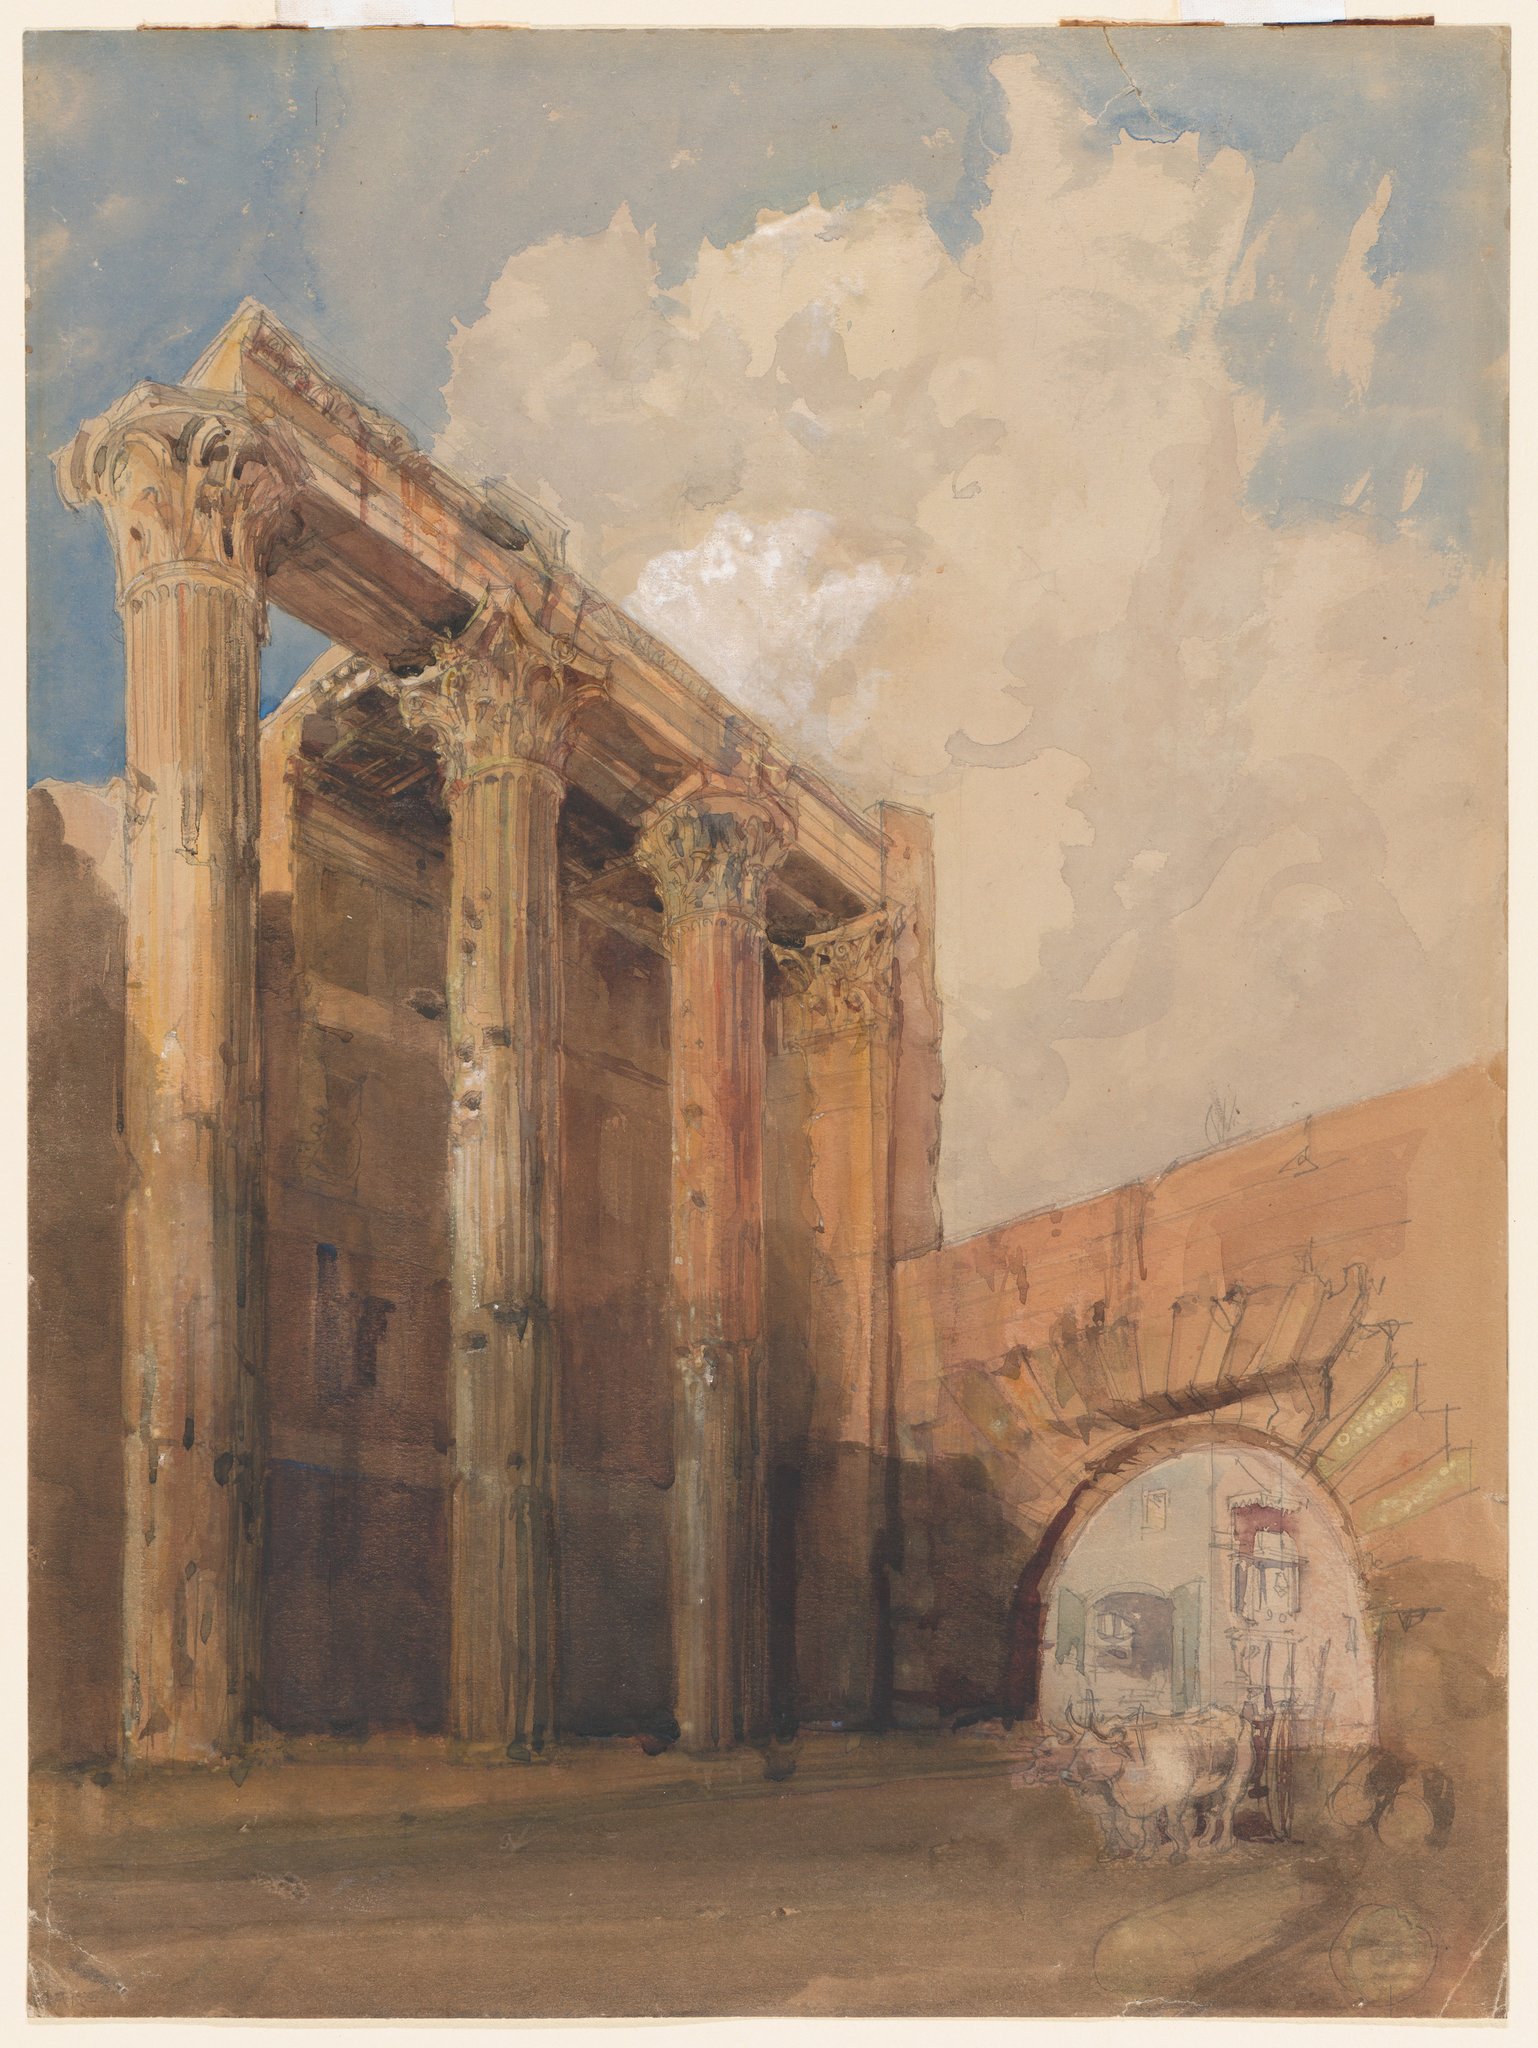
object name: drawing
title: Temple of Mars Ultor, Rome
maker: james holland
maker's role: artist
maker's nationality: british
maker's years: 1799-1870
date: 1840-1845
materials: graphite, watercolor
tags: columns,temples,ruins